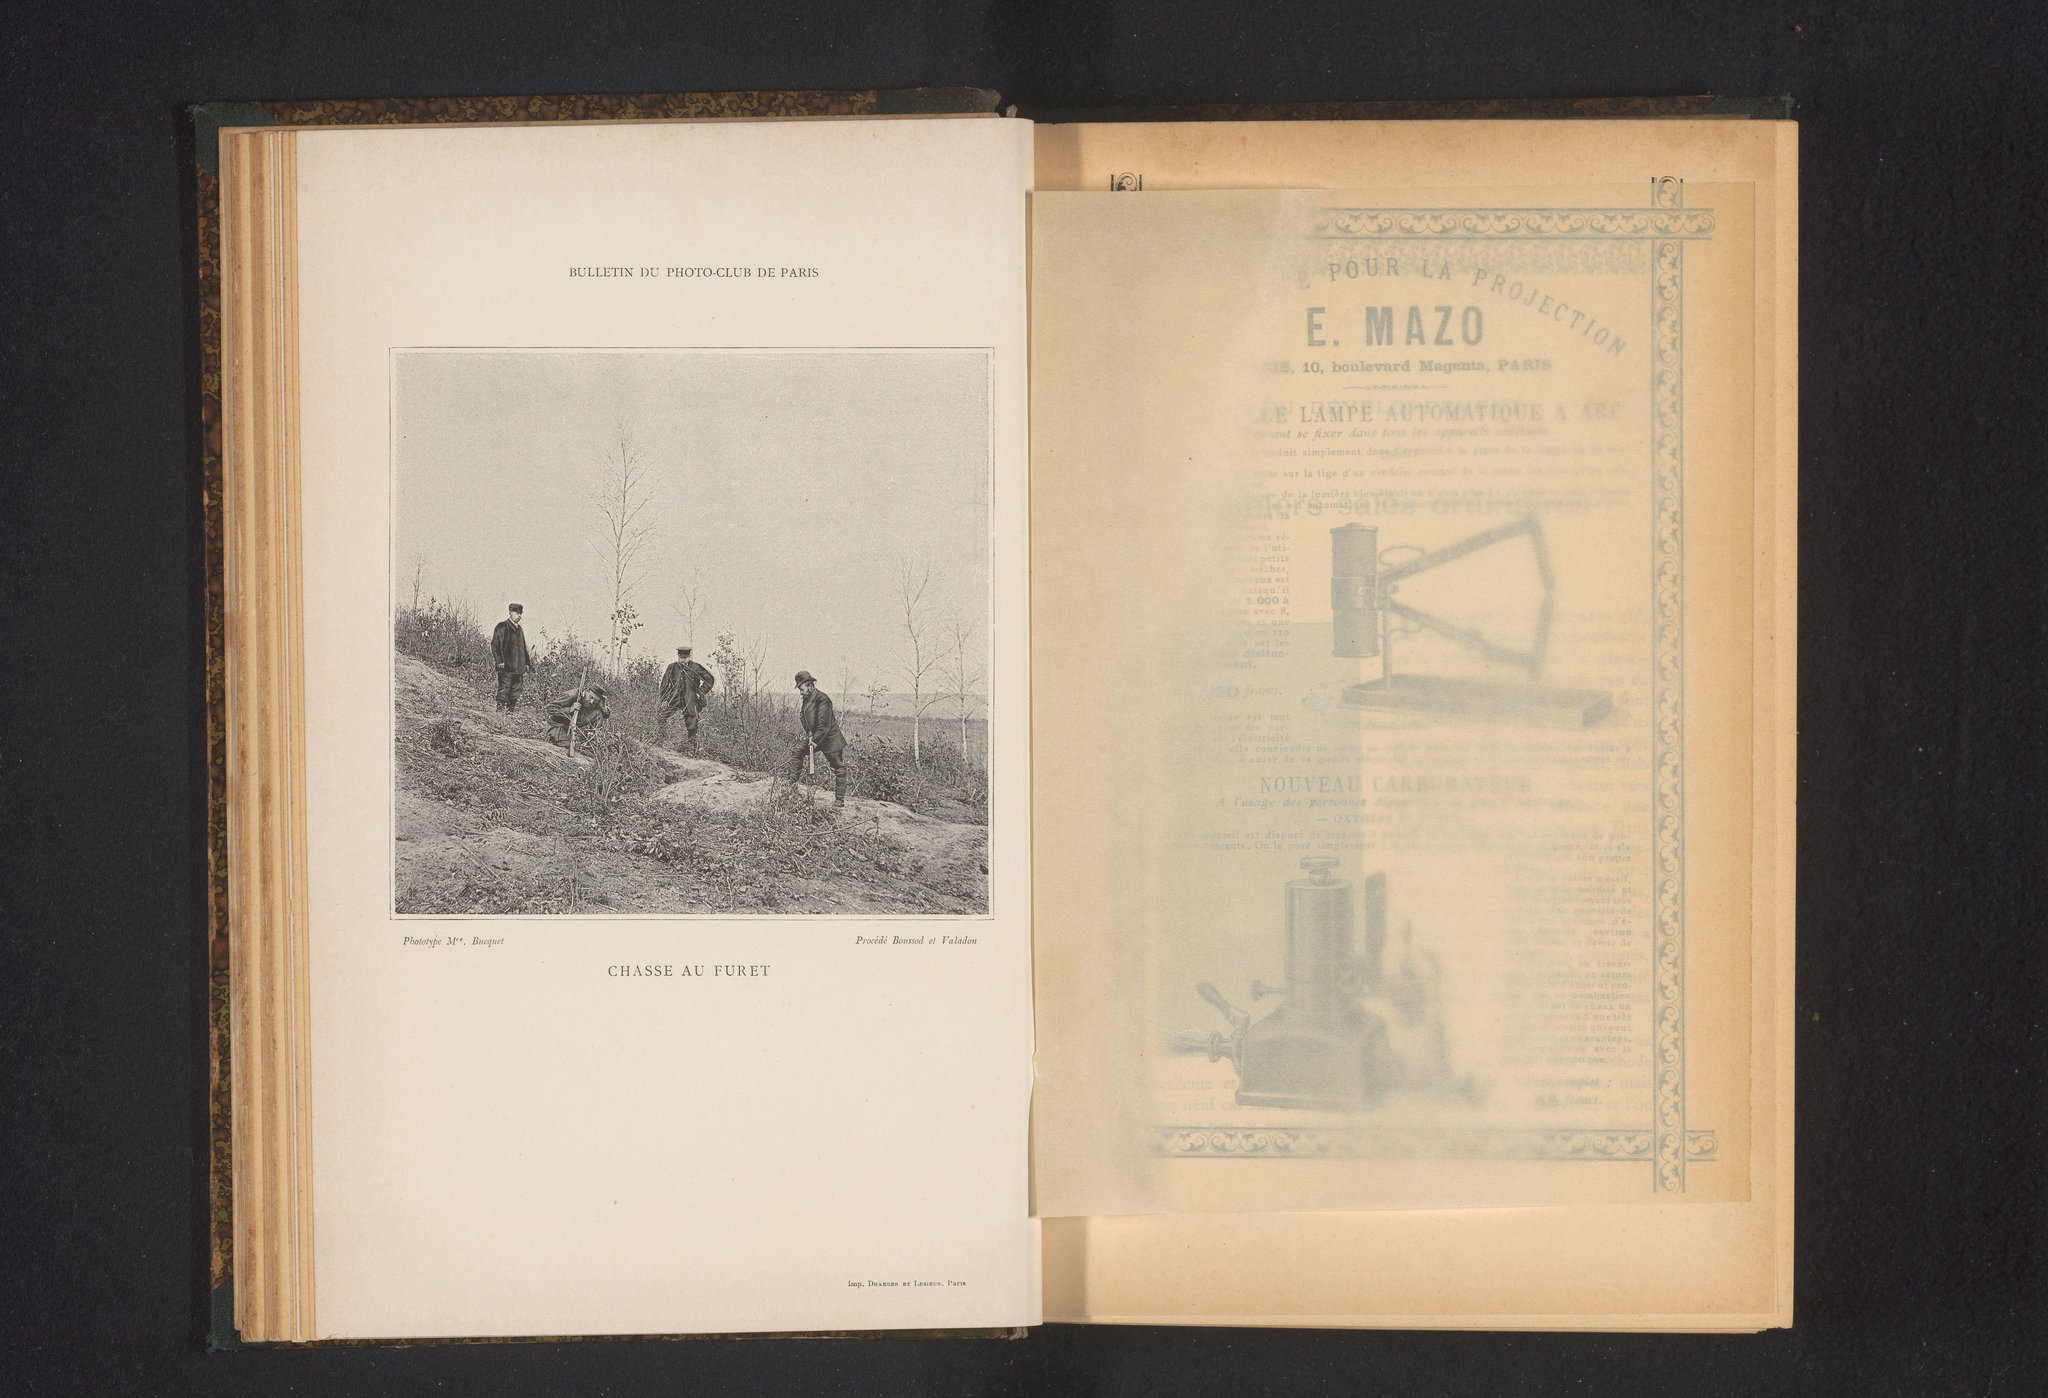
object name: photomechanical print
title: Vier mannen jagen op fretten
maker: maurice bucquet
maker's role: fotograaf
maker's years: 1860-1921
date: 1890-1895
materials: paper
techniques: autotype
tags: beasts of prey, predatory animals: ferret, hunters hunting (n.b.: in 1988-1990 this notation denoted the concept of 43c11421 'hunters resting during the hunt')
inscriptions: inscription: ‘Bulletin du Photo-Club de Paris’, inscription: ‘Procédé Boussod et Valadon’